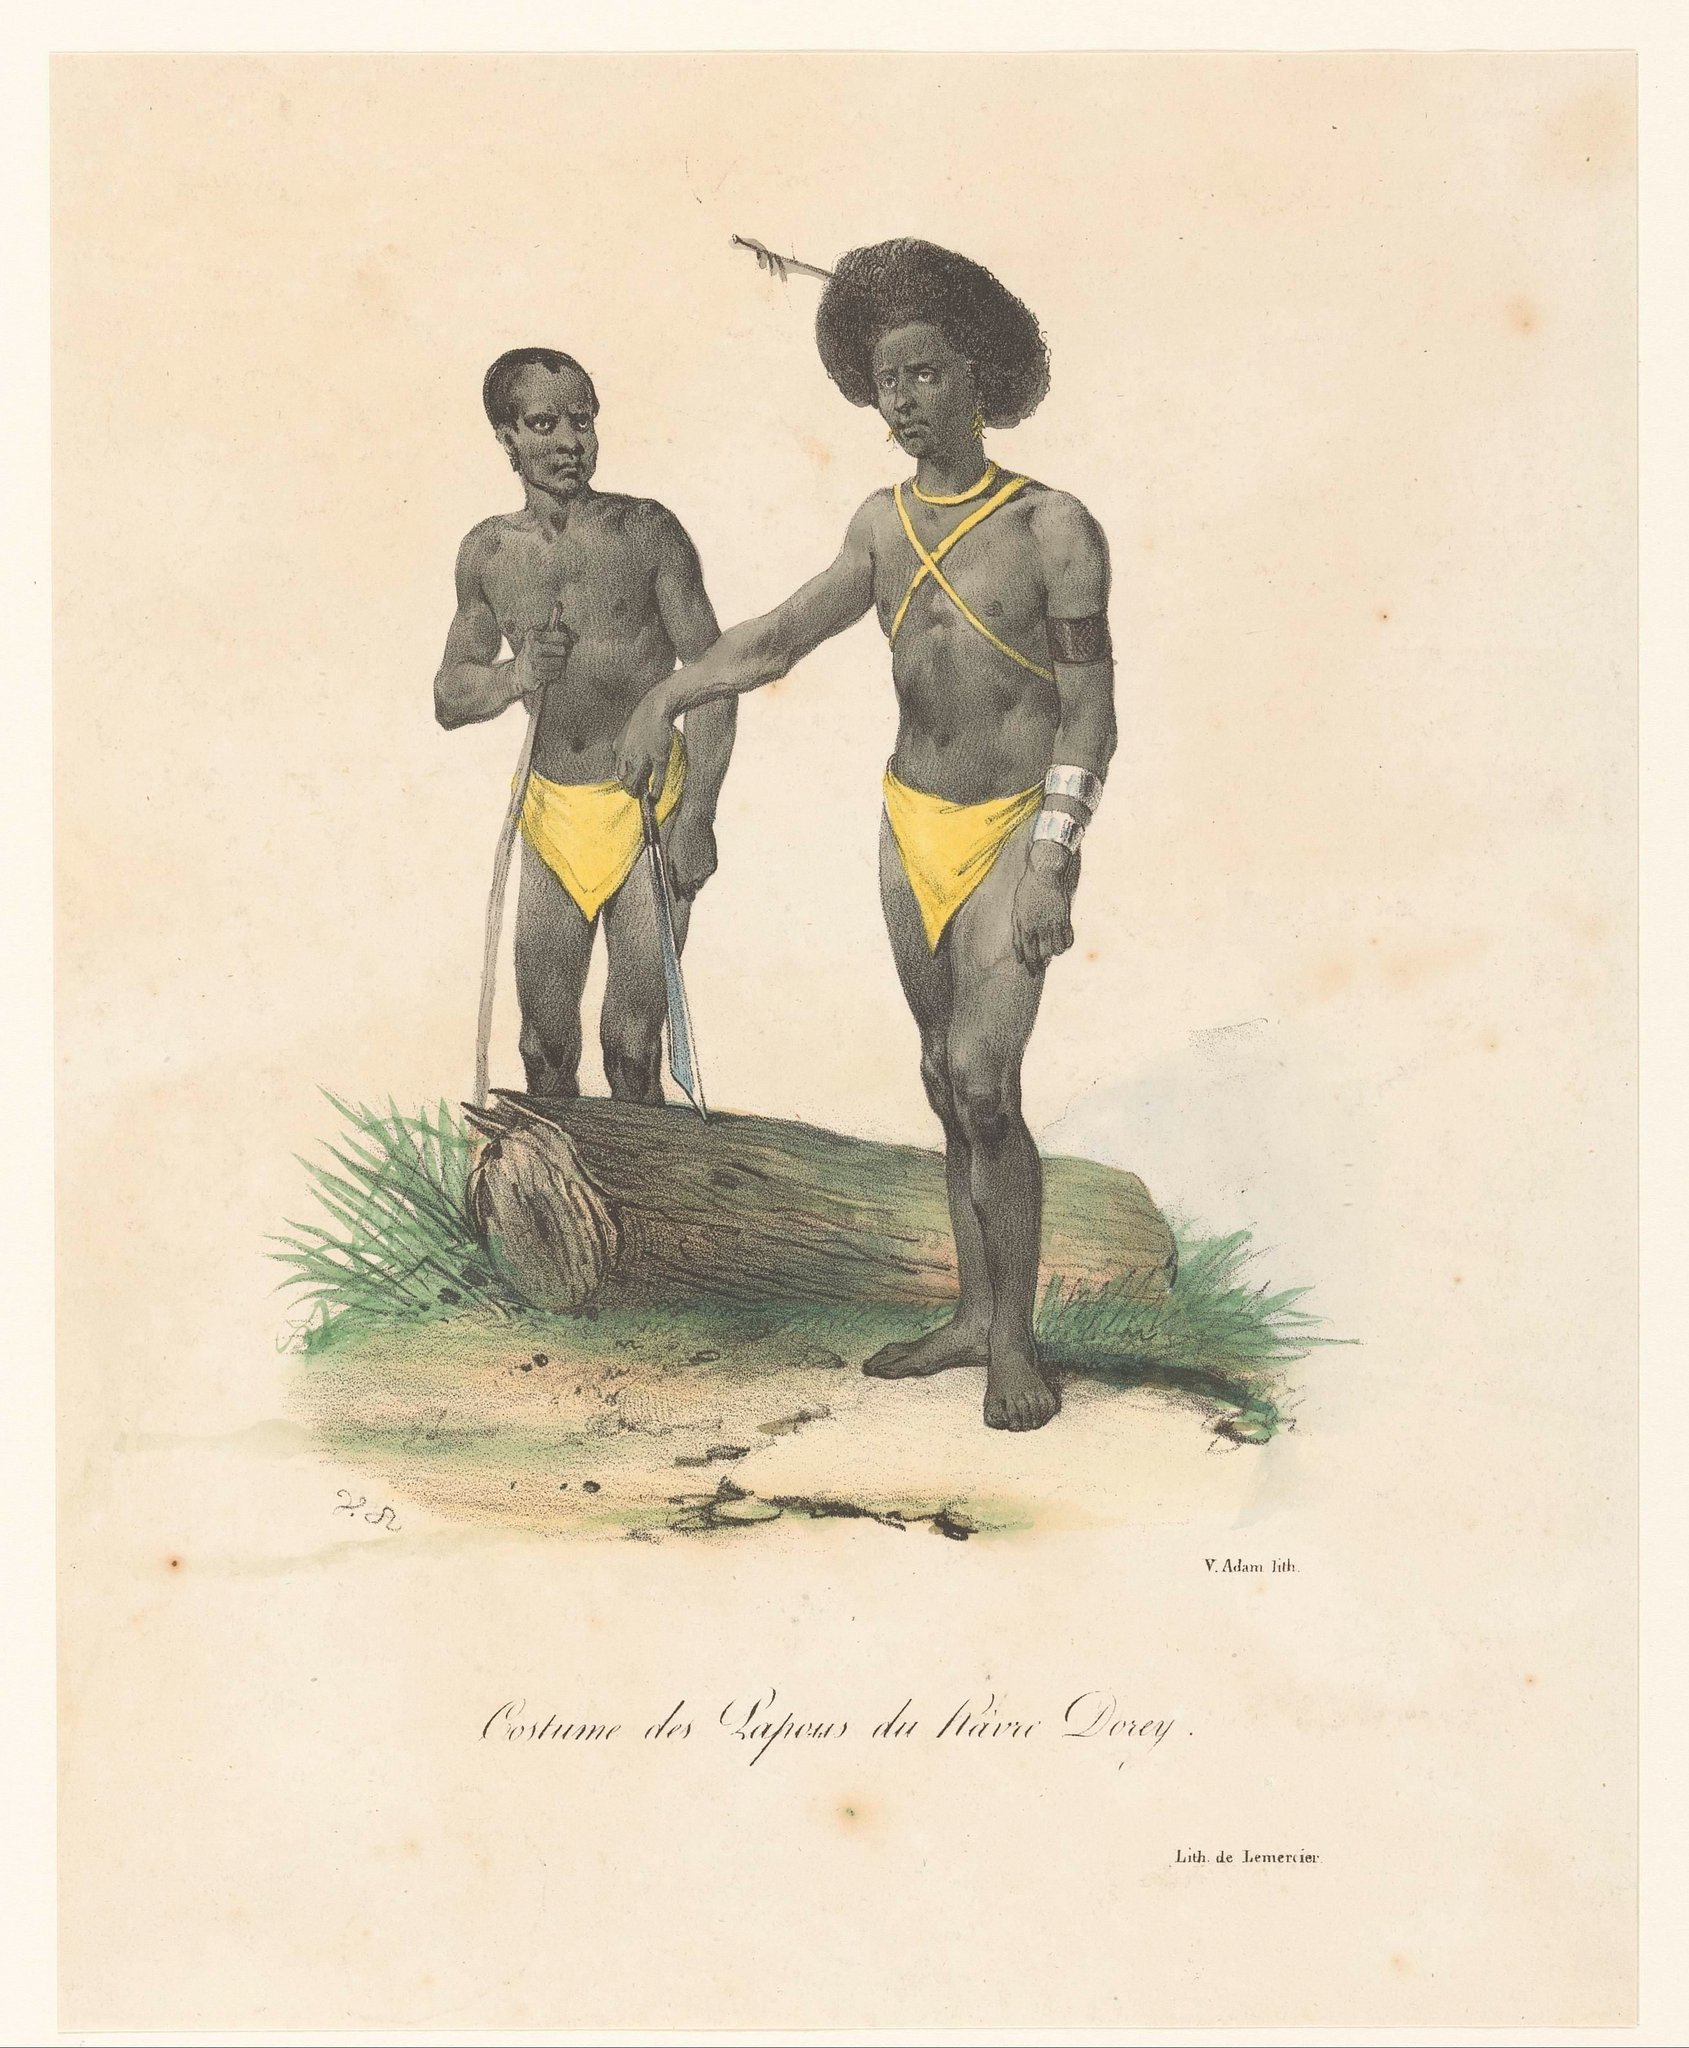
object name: print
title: Ontdekkingsreis van de Astrolabe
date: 1830-1835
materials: paper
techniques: hand coloring, lithograph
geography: paris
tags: folk costume, regional costume, australian and oceanian races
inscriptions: collector's mark: Lugt 2228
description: In 1830-1833 werd de publicatie 'Voyage de la corvette l'Astrolabe exécuté par ordre du roi, pendant les années 1826-1827-1828-1829 (...)' in zeventien delen uitgegeven door J. Tastu in Parijs. De auteur van dit verslag van een Franse expeditie met het schip 'l'Astrolabe' was J. Dumont d'Urville. De publicatie was verrijkt met illustraties van verschillende lithografen, naar ontwerp van Louis-Auguste de Sainson, die zelf had deelgenomen aan de expeditie.